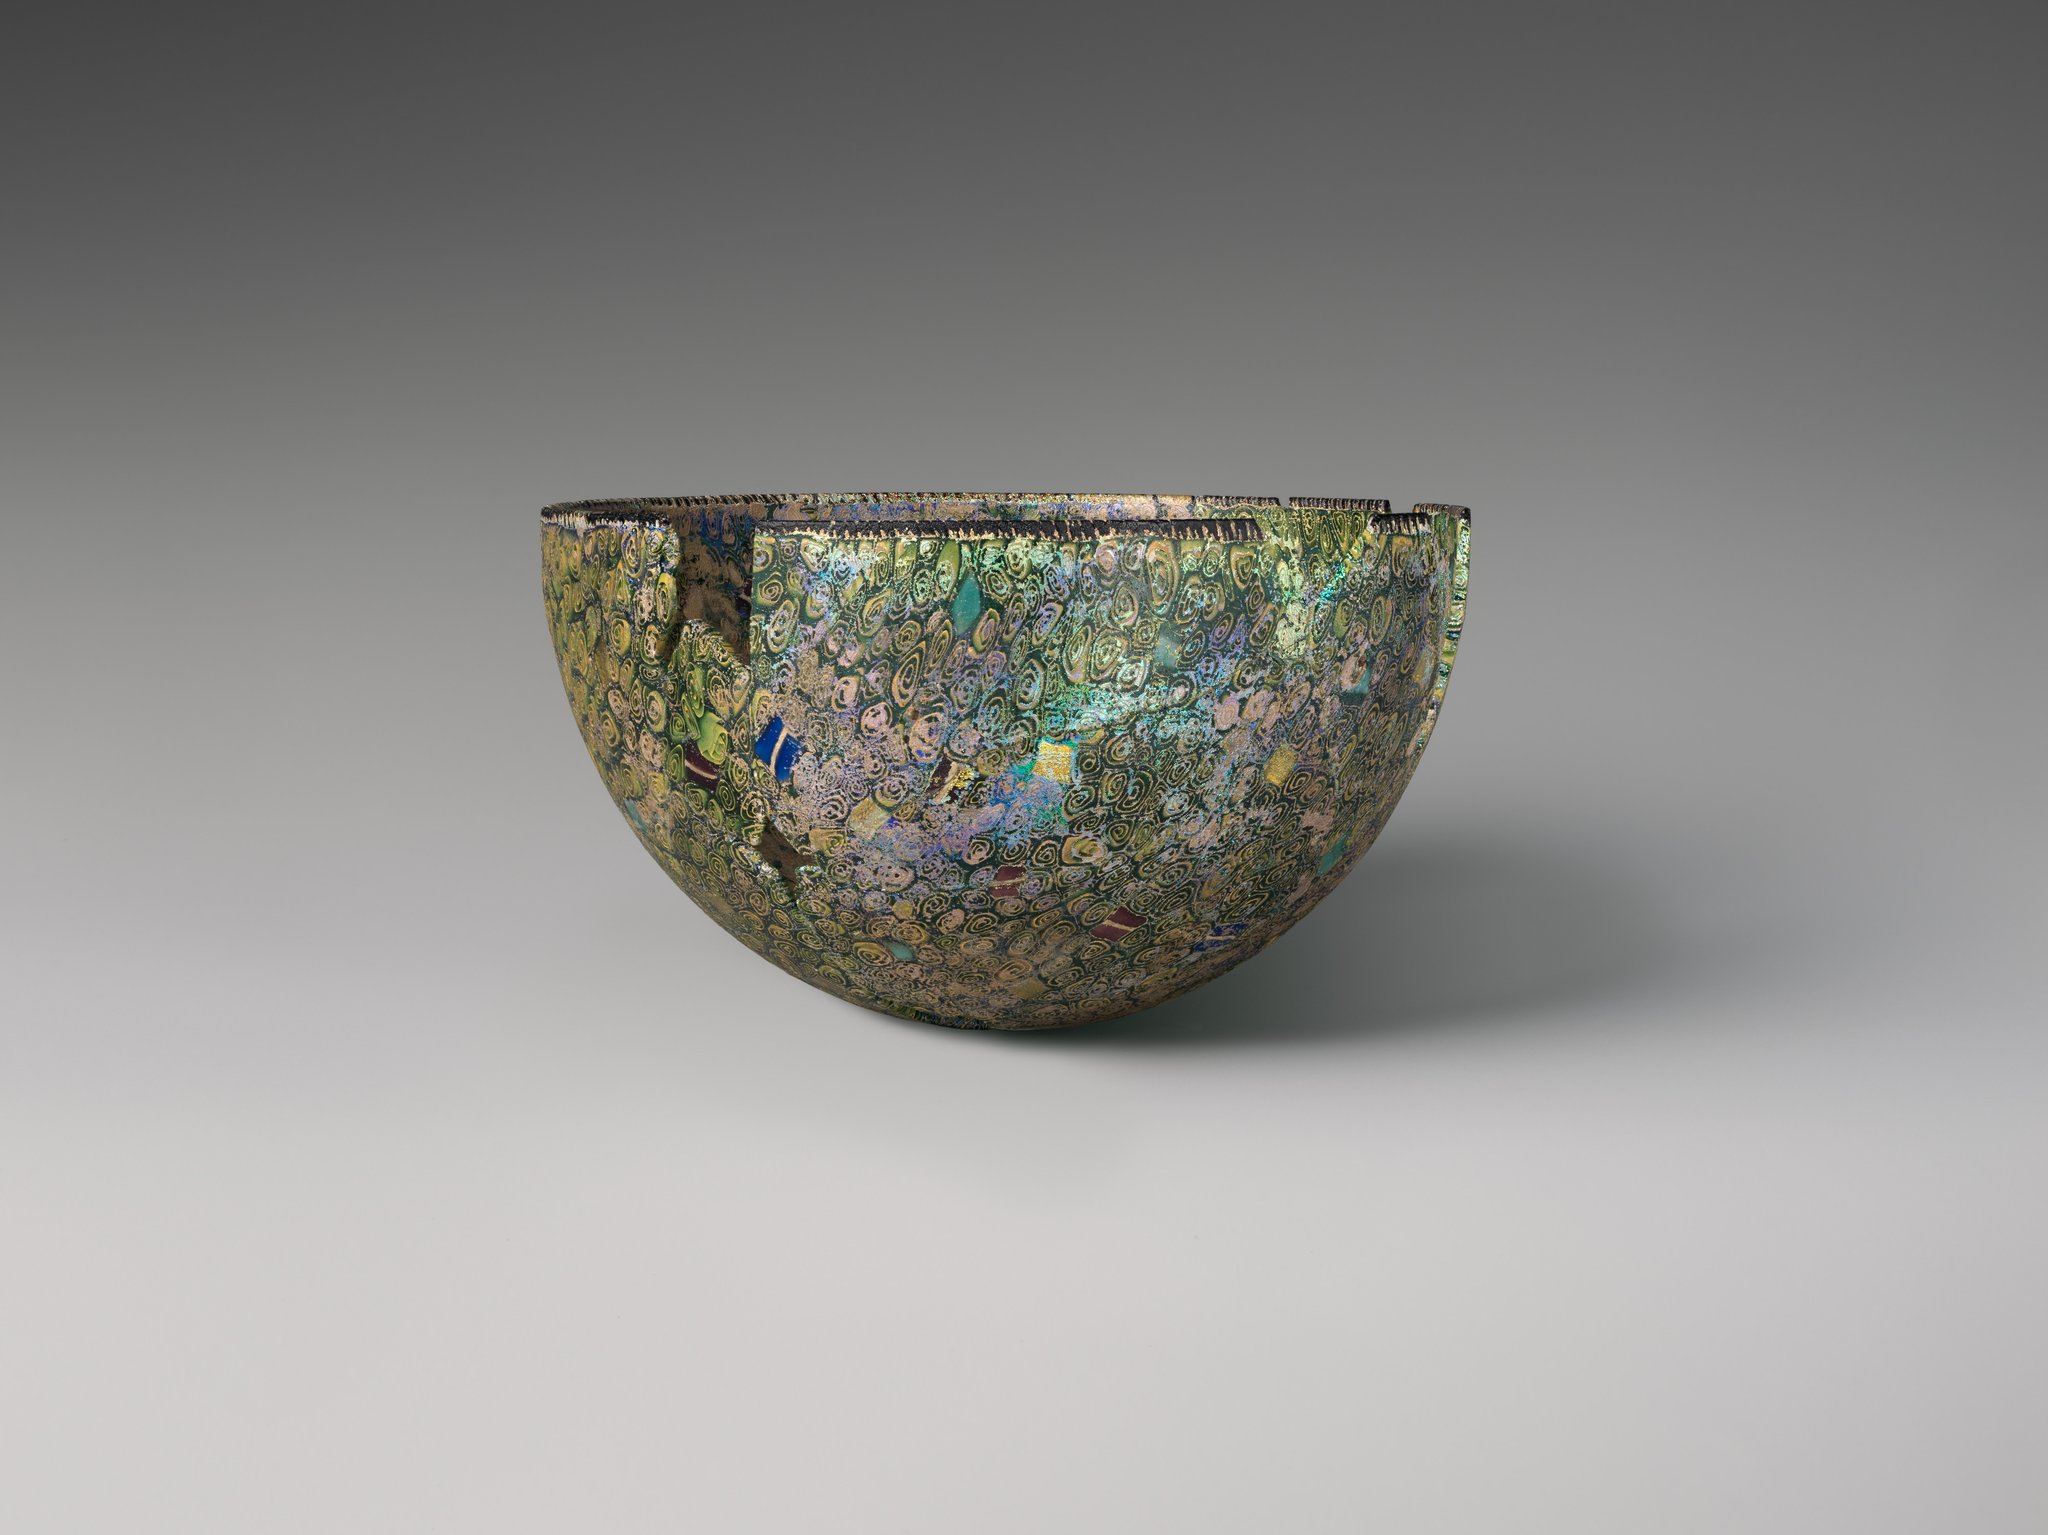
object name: bowl, mosaic gold glass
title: Mosaic gold-glass hemispherical bowl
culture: greek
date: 200-168 BCE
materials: glass